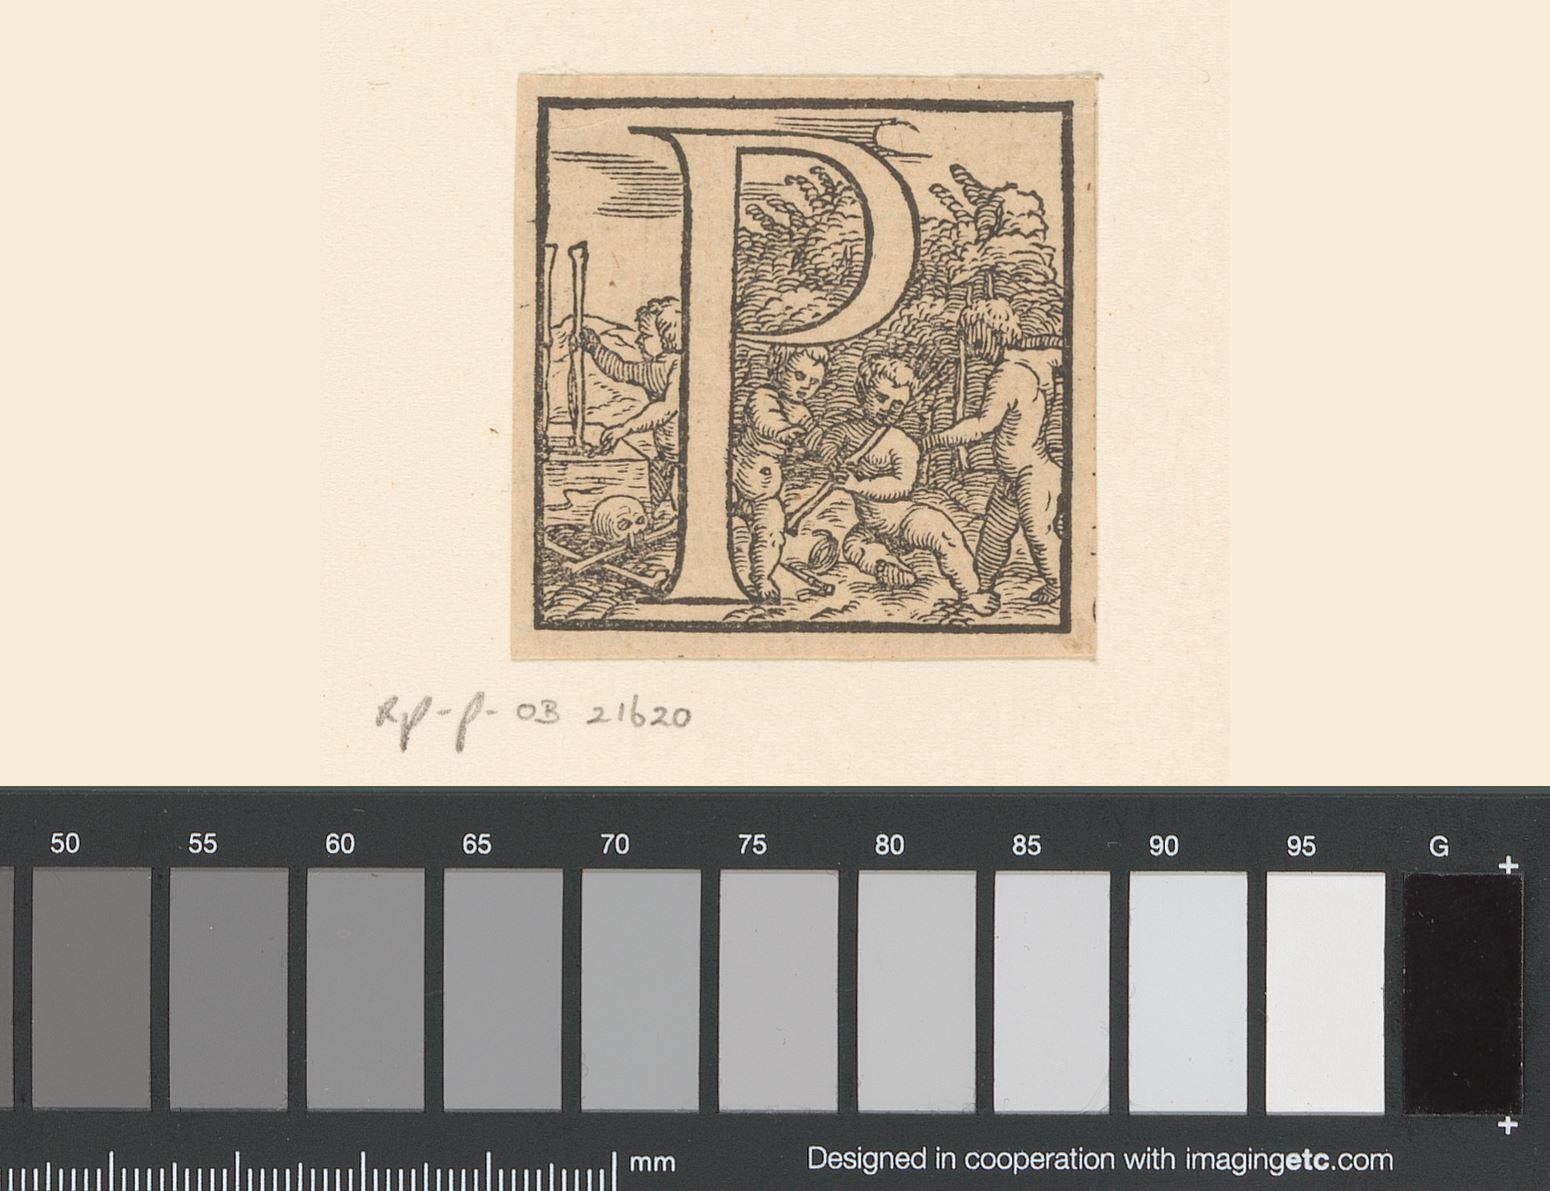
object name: book illustration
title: Versierde initialen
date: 1543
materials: paper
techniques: woodcut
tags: letters, alphabet, script, physiology and anatomy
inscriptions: collector's mark: Lugt 2227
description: Prent uit: Vesalius, Andreas. De Humani Corporis Fabrica. Bazel: Jan Herpst, 1543.